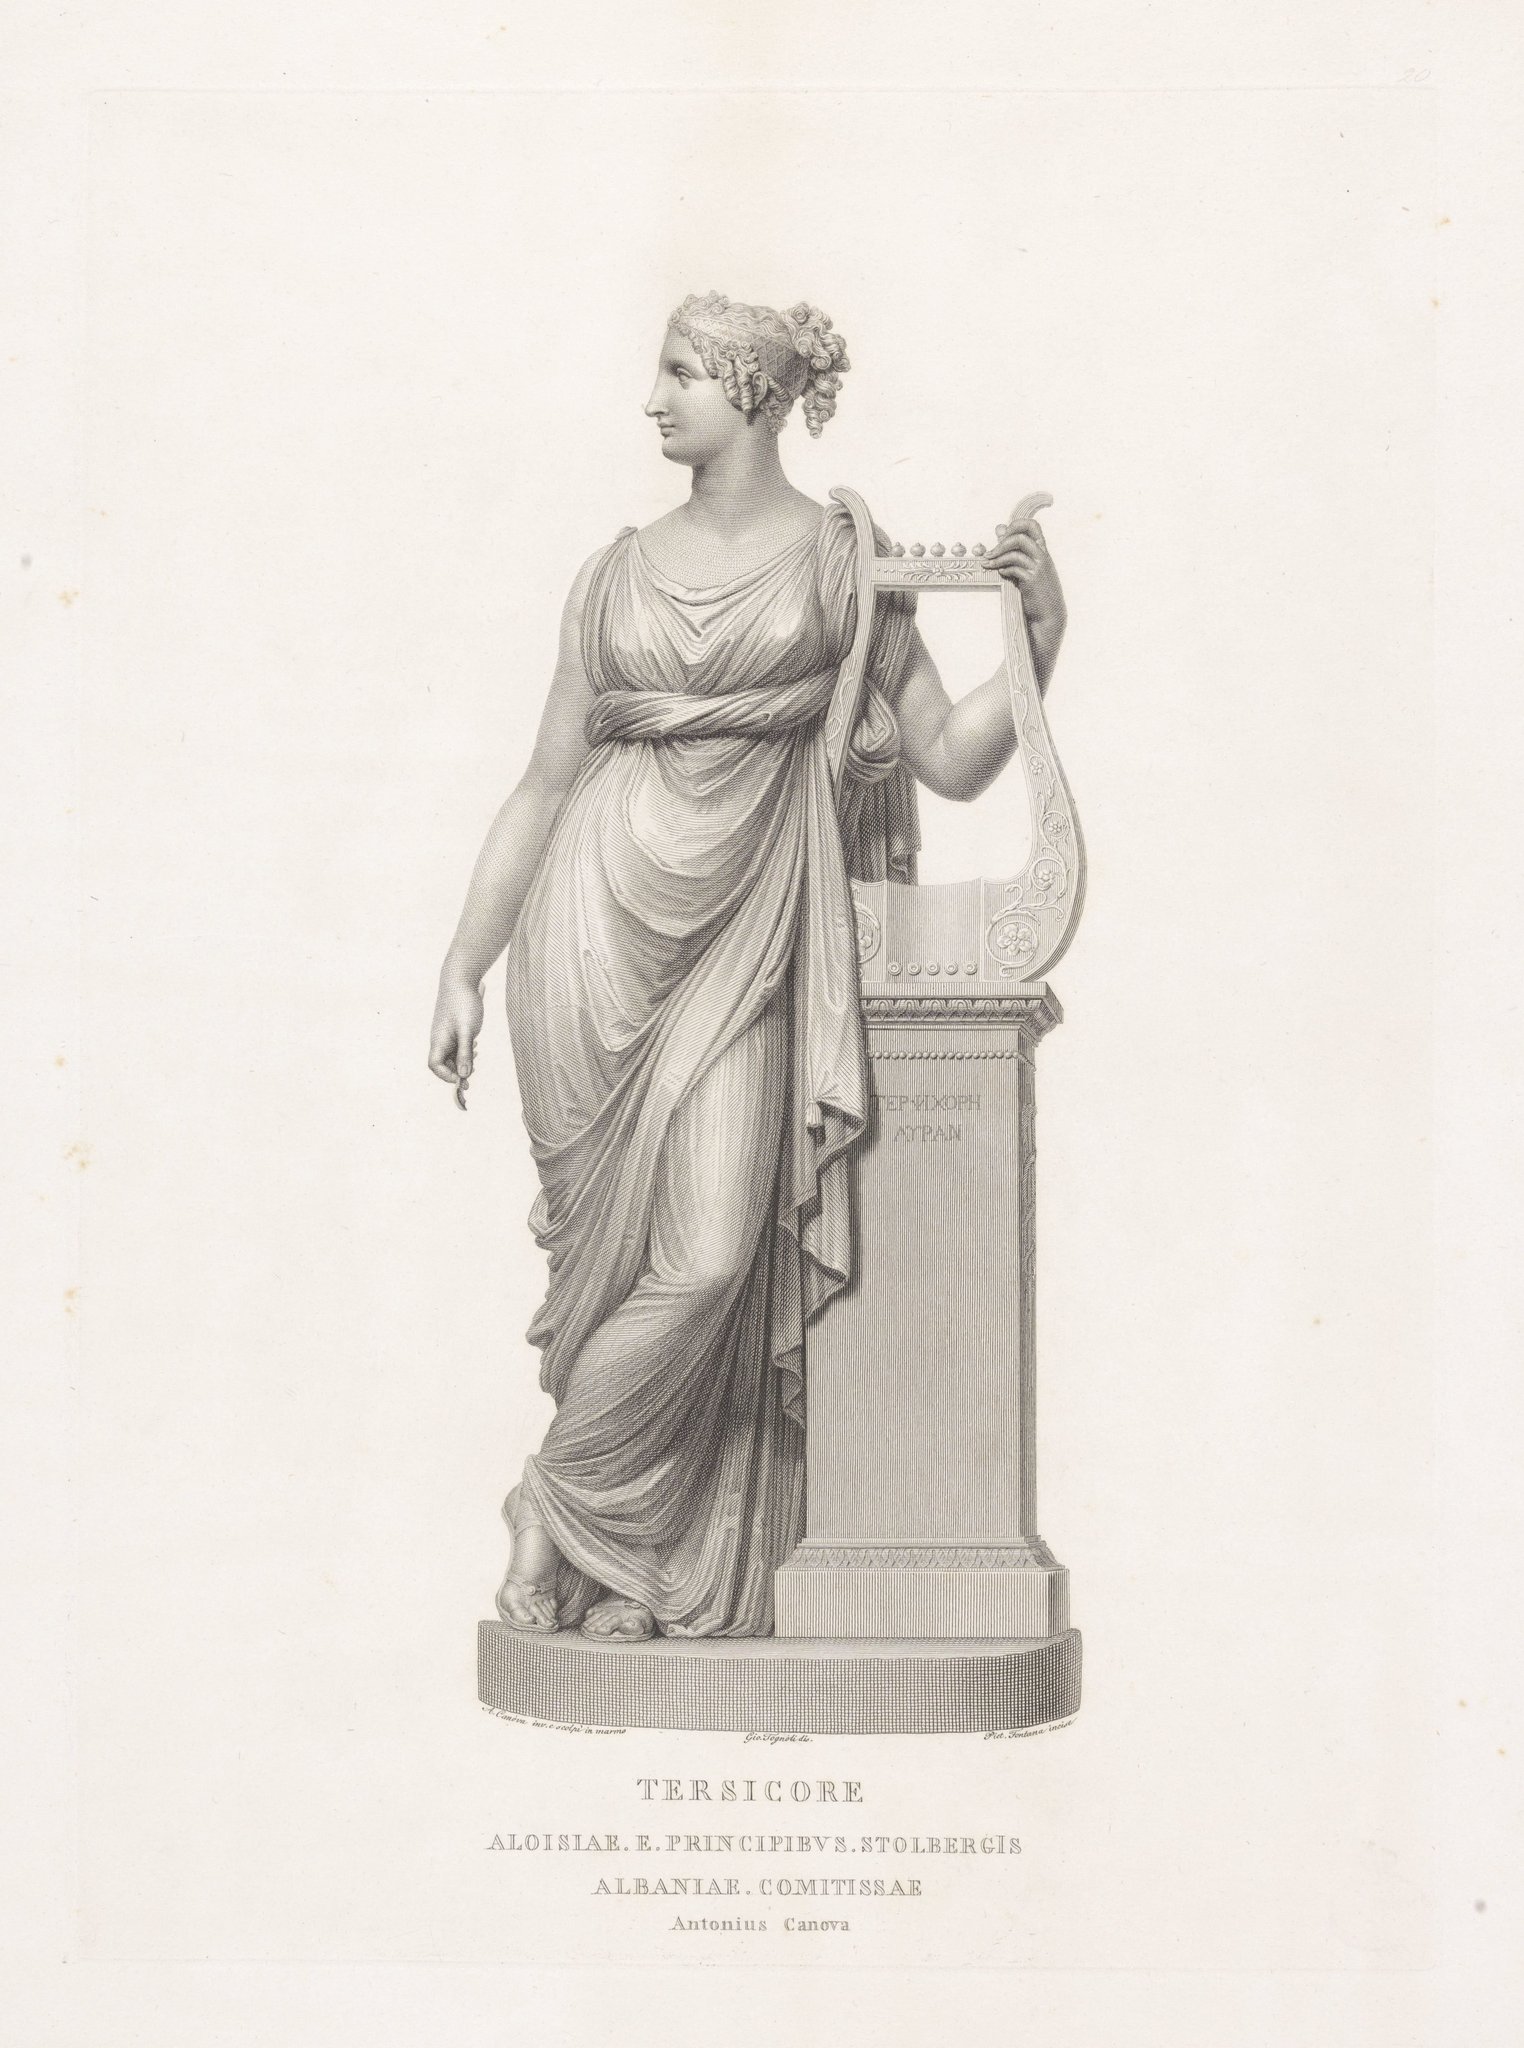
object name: print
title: Terpsichore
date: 1816-1837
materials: paper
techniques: engraving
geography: italy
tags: piece of sculpture, reproduction of a piece of sculpture, terpsichore (one of the muses); 'terpsicore' (ripa)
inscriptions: collector's mark: Lugt 12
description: Deze prent maakt deel uit van een reeks van onbekende omvang met voorstellingen van sculpturen van Antonio Canova door verschillende prentmakers naar tekeningen van Giovanni Tognolli. Originele sculptuur door Canova staat in het Cleveland Museum of Art, Cleveland, Ohio, USA.